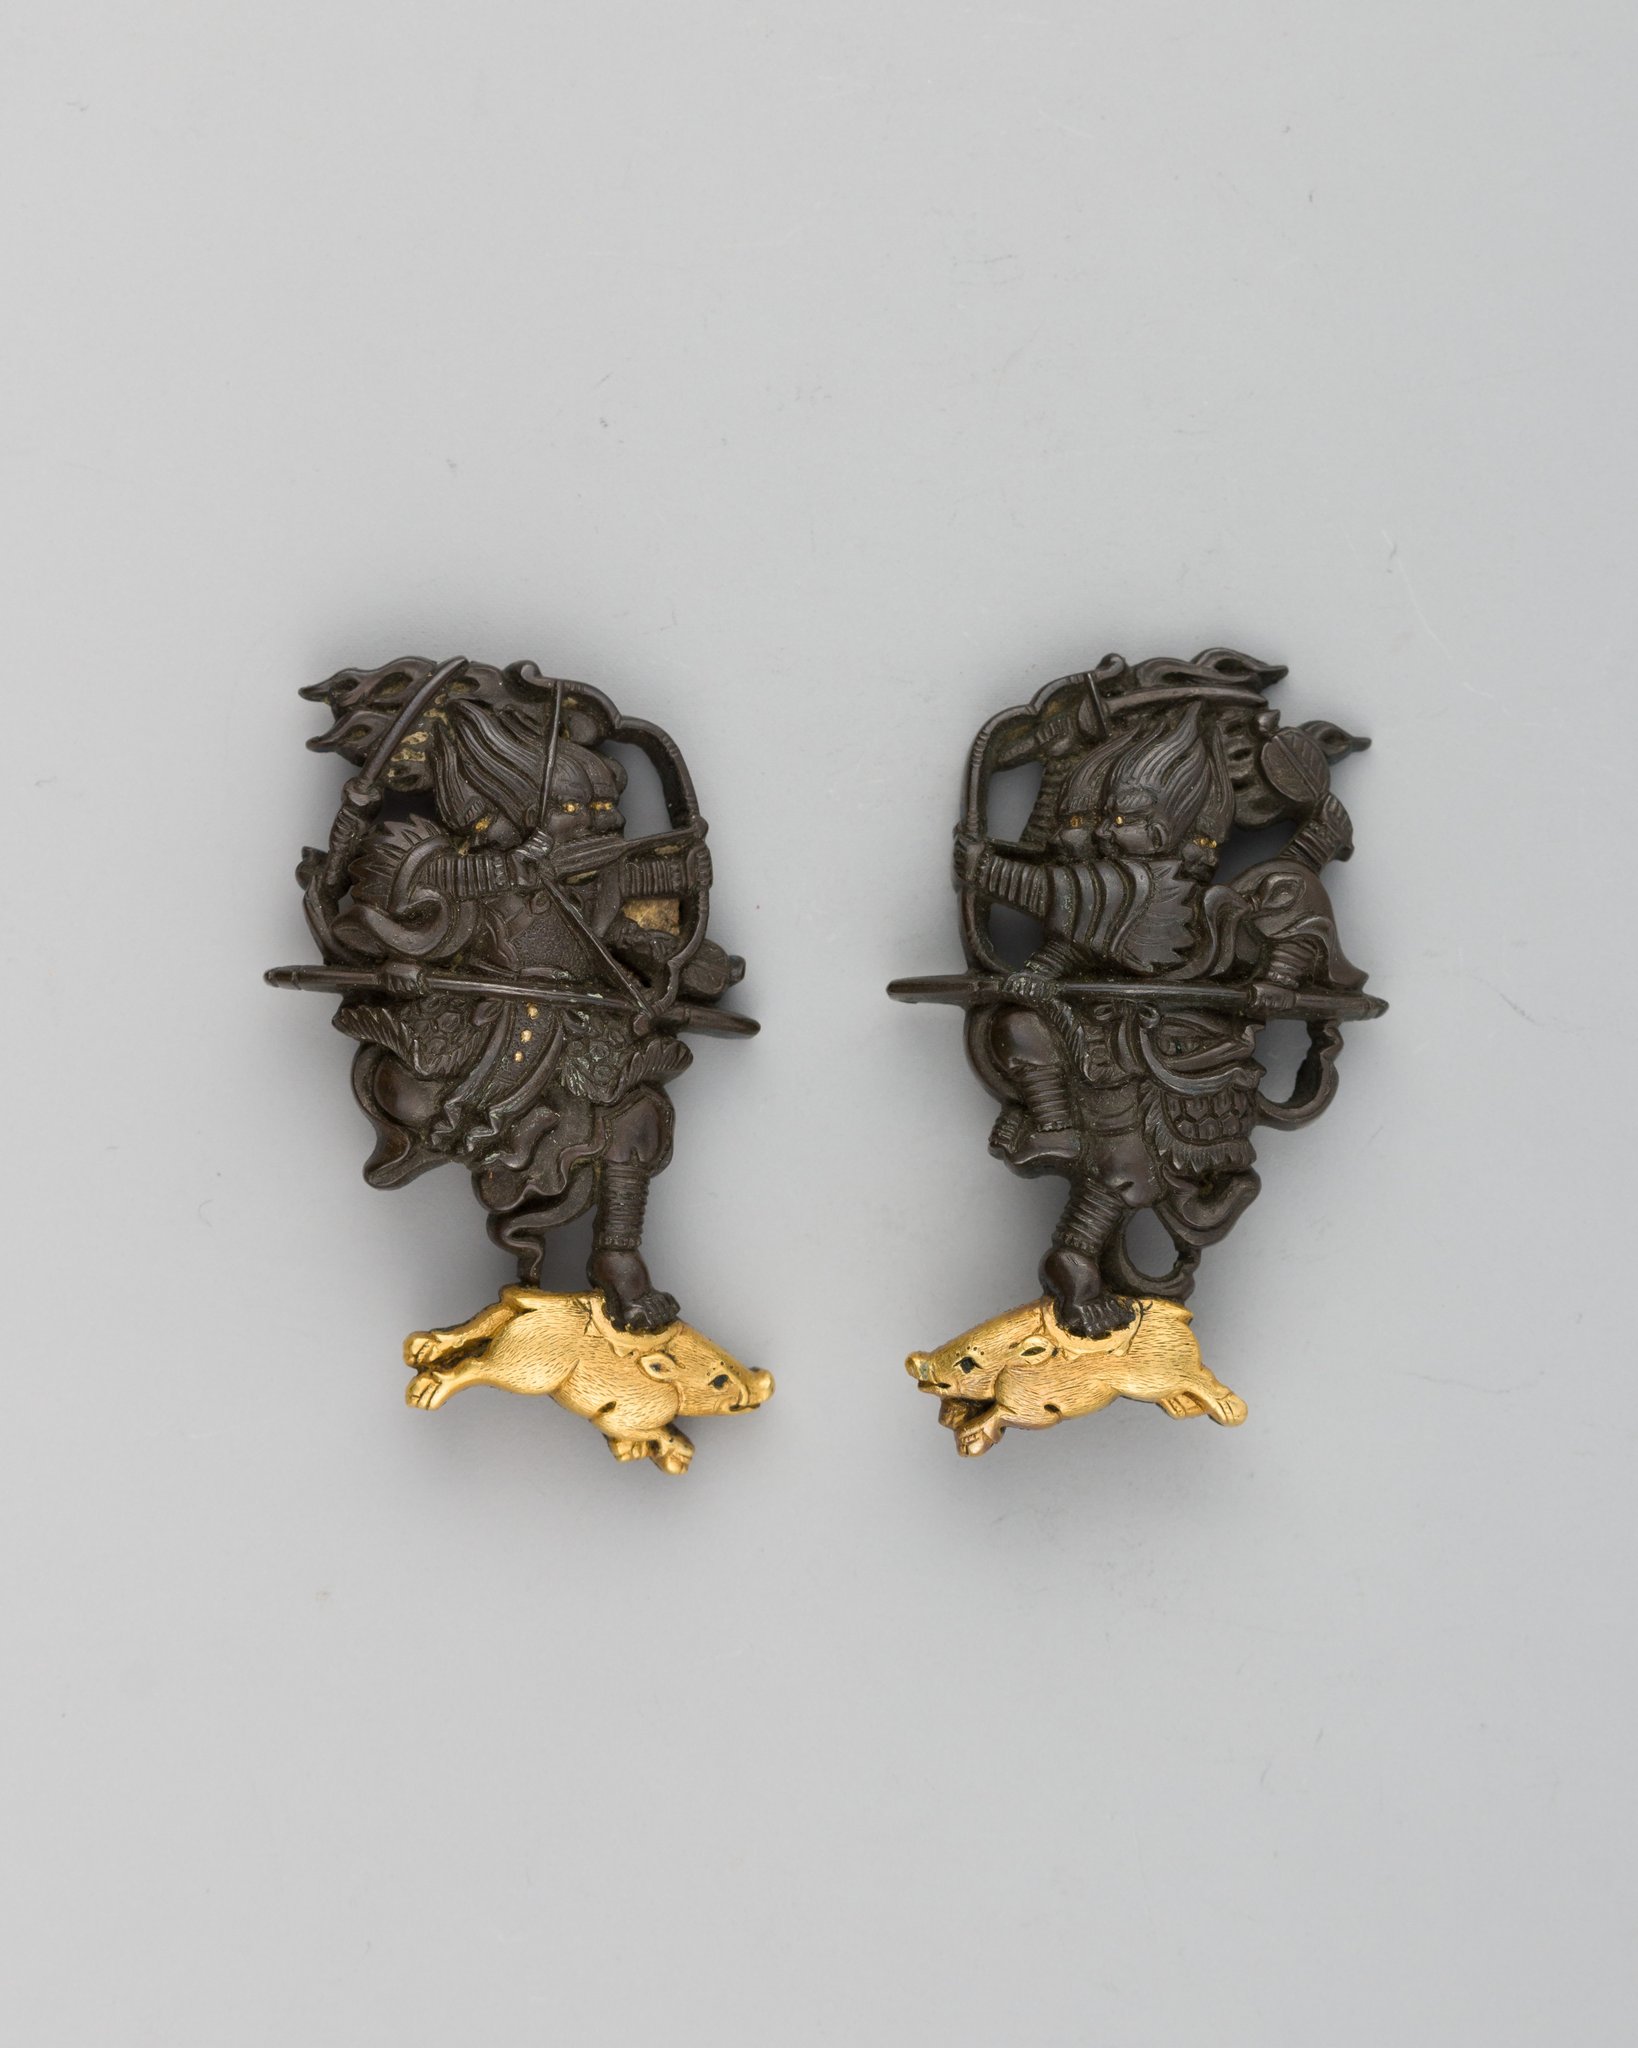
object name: pair of sword grip ornament menuki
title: Pair of Sword-Grip Ornaments (Menuki)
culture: japanese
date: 1750-1787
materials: silver alloy, gold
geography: japan